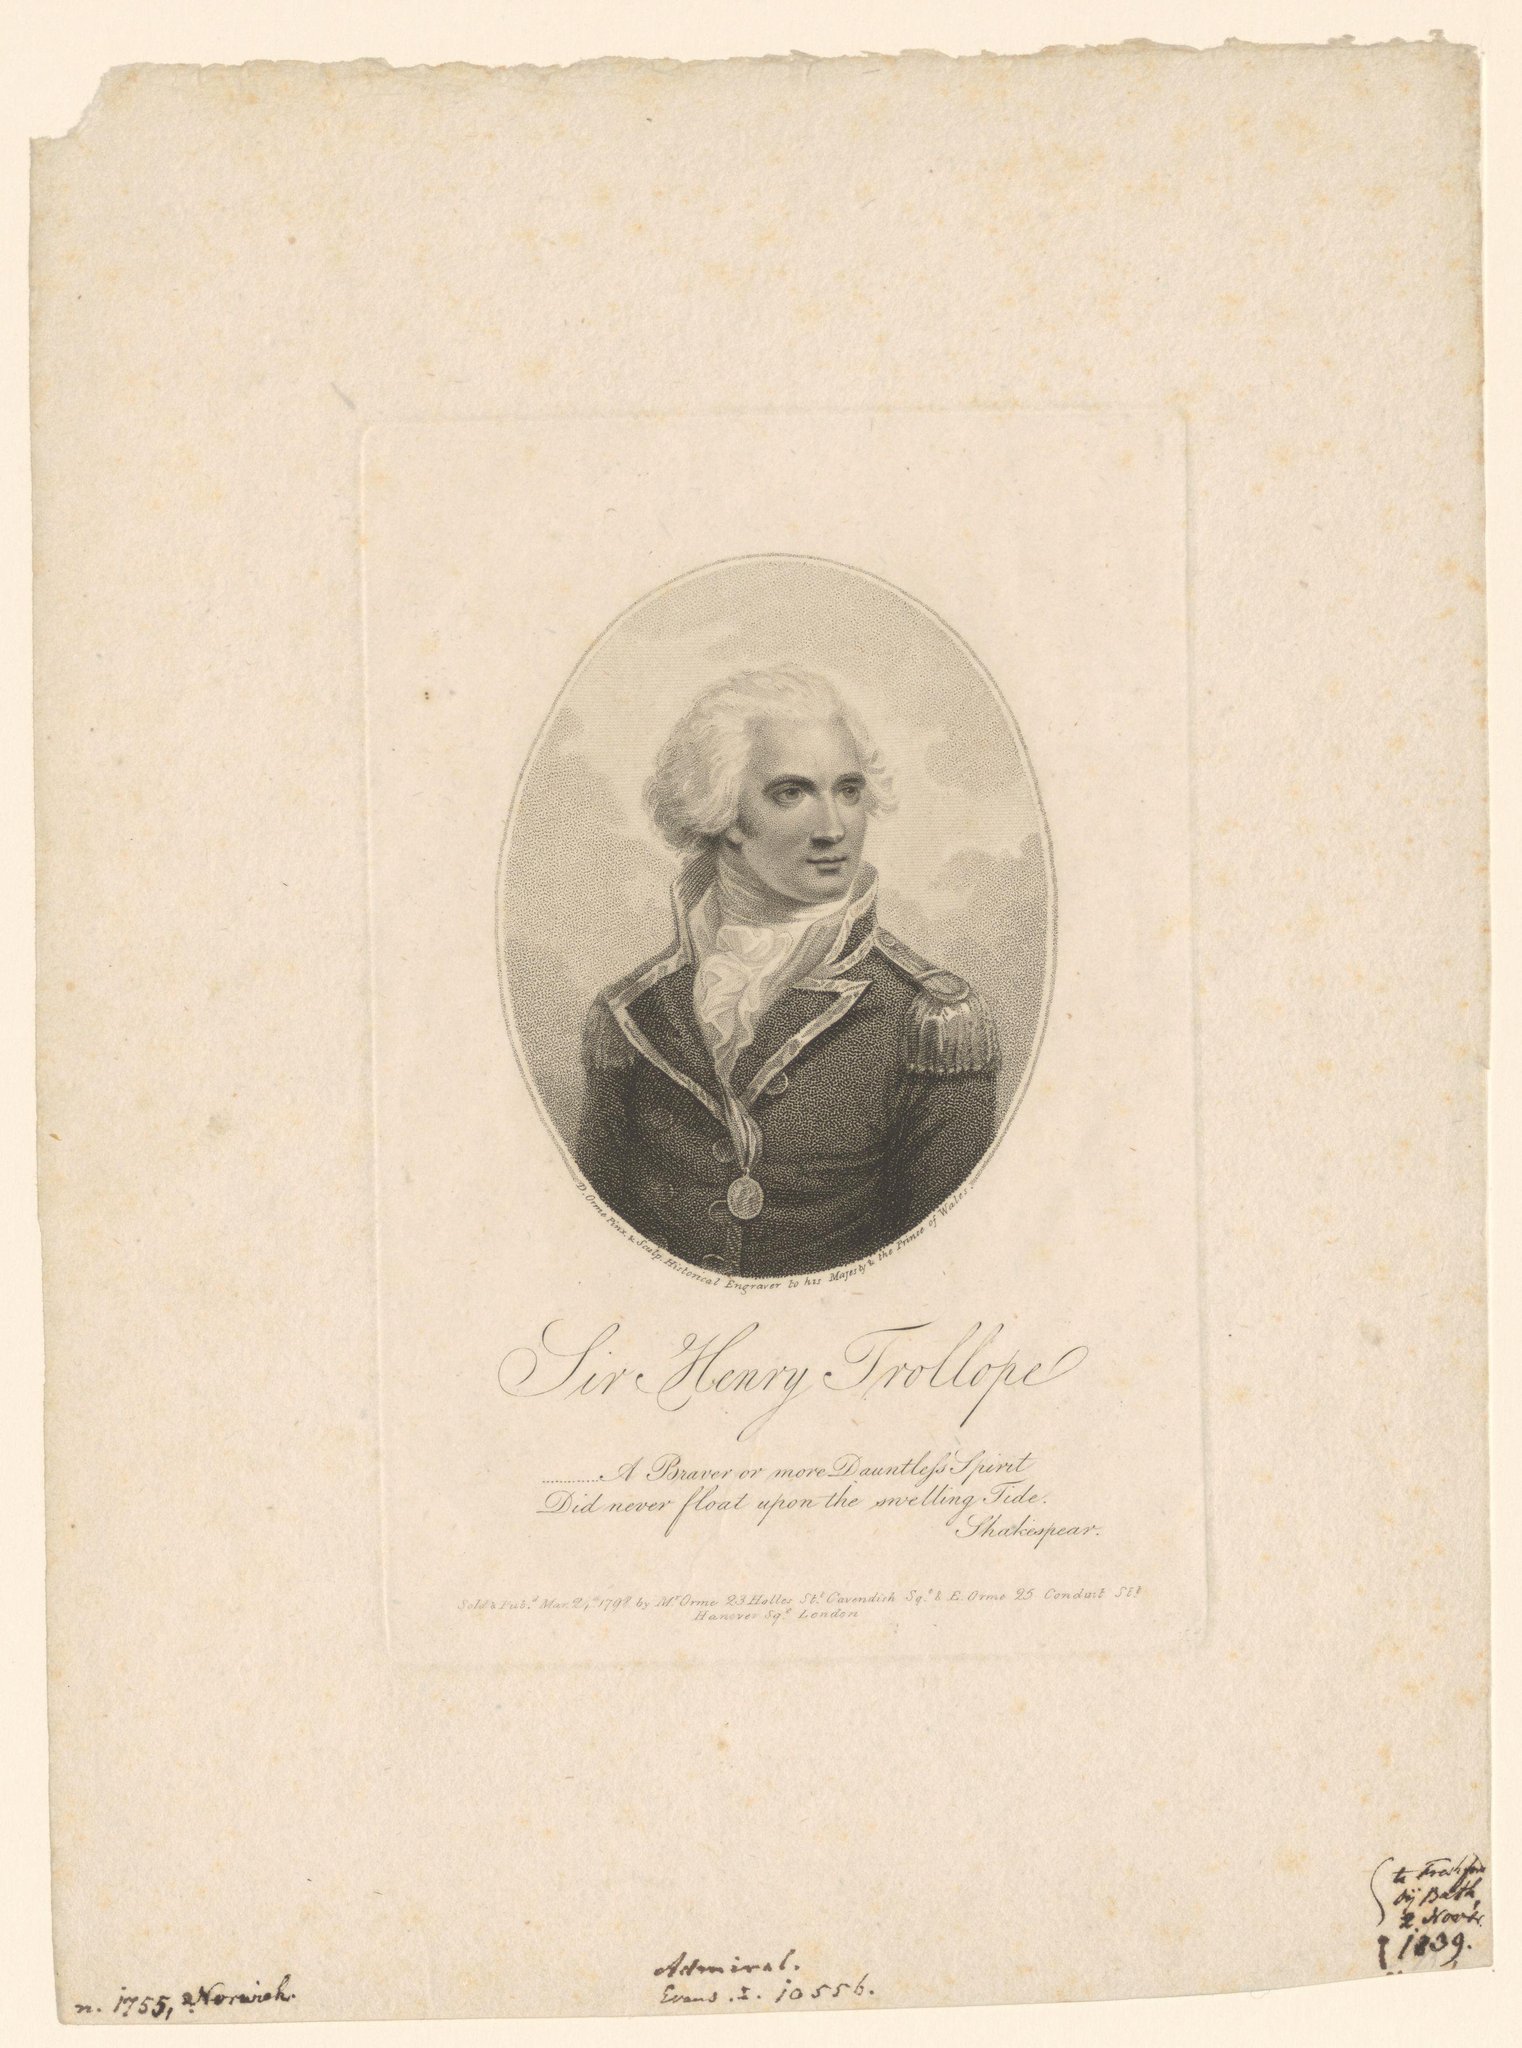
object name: print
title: Sir Henry Trollope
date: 1703-1798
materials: paper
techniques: engraving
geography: london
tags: historical persons, commander-in-chief, admiral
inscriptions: inscription, collector's mark: Lugt 2228